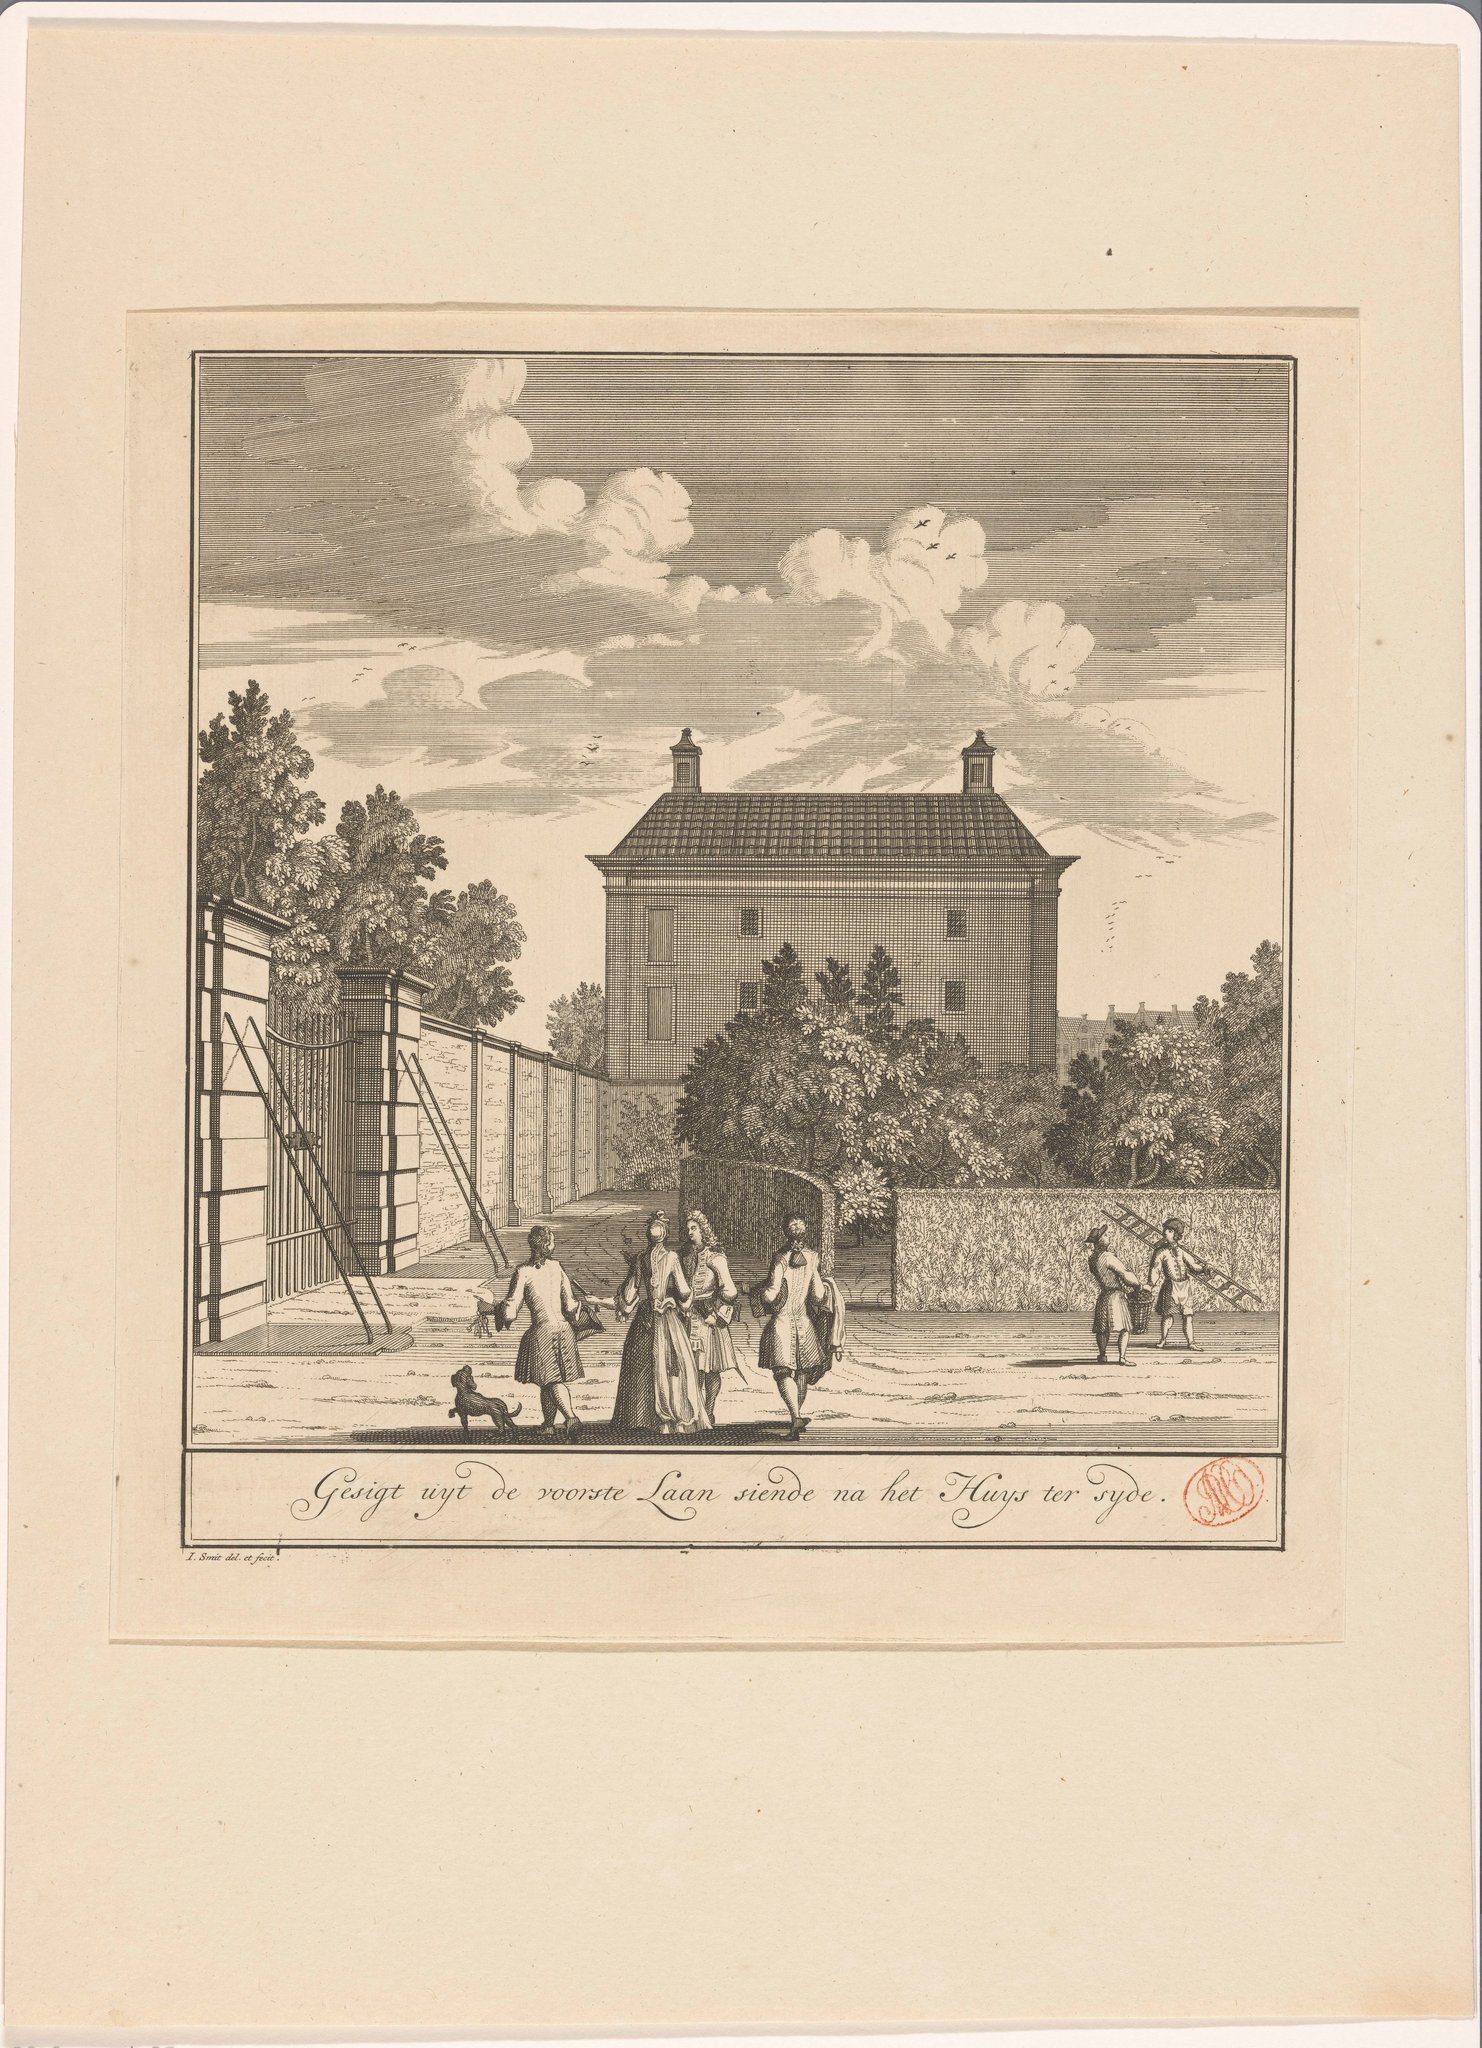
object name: print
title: Gesigt uyt de voorste Laan siende na het Huys ter syde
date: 1723-1748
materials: paper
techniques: engraving, etching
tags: alms-house (dutch: 'hofje'), public welfare, key, french or architectonic garden; formal garden, gate, entrance, gardening, orchard, old-people's home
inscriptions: collector's mark: Lugt 195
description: Gezicht op de zijkant en een deel van de tuin van het Corvershof aan de Nieuwe Herengracht te Amsterdam. Links het hek aan de straatkant. Op de voorgrond staan drie mannen en een vrouw. De man links heeft een sleutelbos in zijn hand, naast hem staat een hondje. In het midden de toegang tot de boomgaard. Rechts twee tuinmannen, de één met een mand, de ander met een ladder. Onderdeel van een serie prenten van het in 1723 in gebruik genomen Corvershof, bestemd voor oudere echtparen van Nederduits Gereformeerde (later Hervormde) huize.